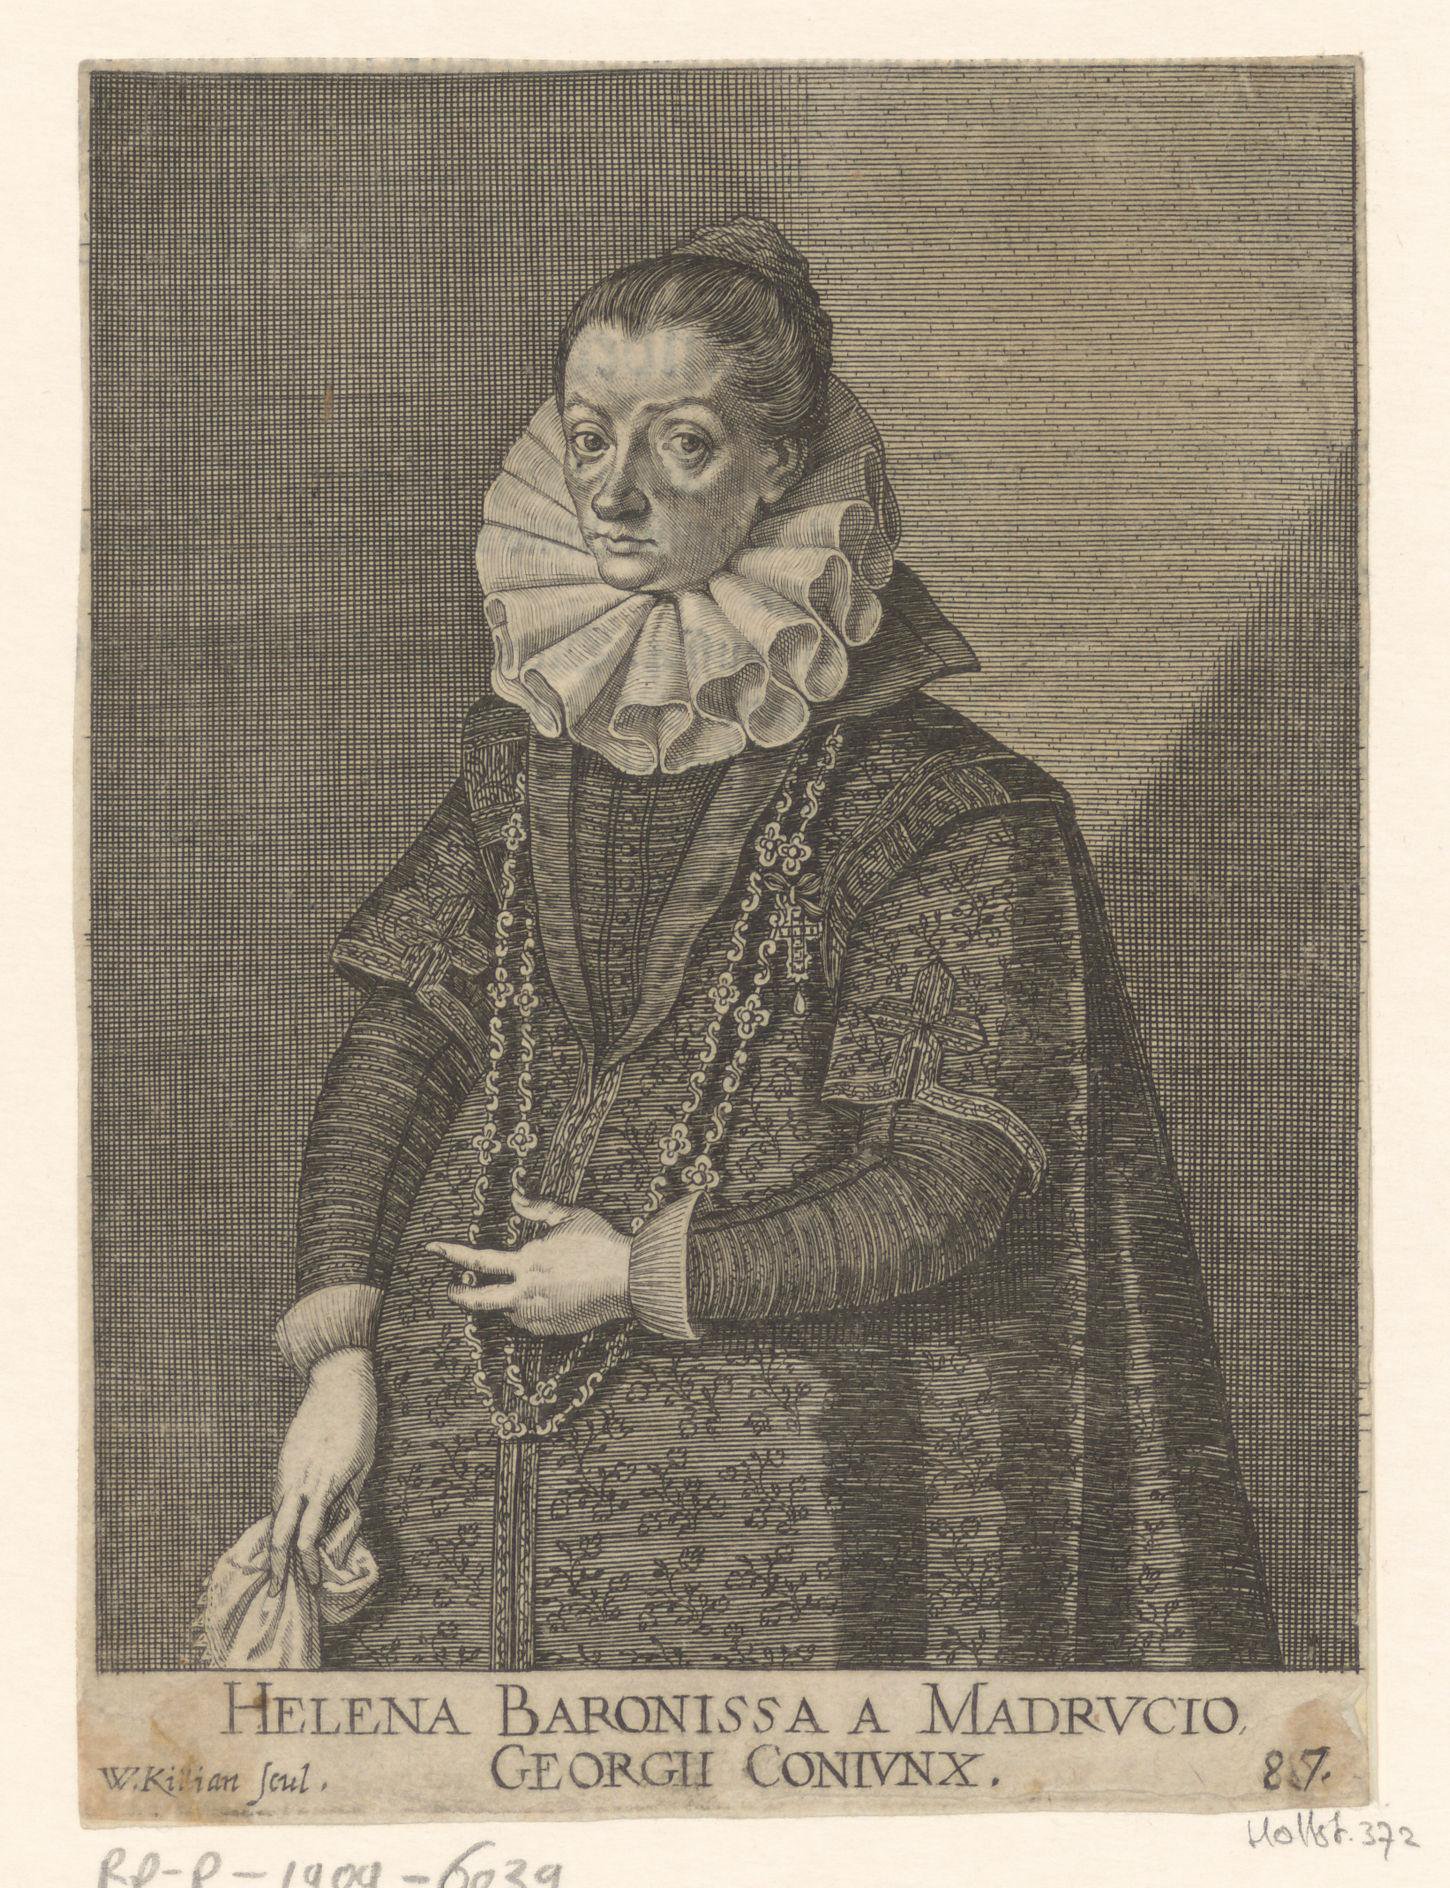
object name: print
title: Portret van Helena Fugger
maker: wolfgang kilian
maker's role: print maker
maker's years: 1581-1662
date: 1591-1662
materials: paper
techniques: engraving, etching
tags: historical persons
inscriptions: collector's mark: Lugt 2228